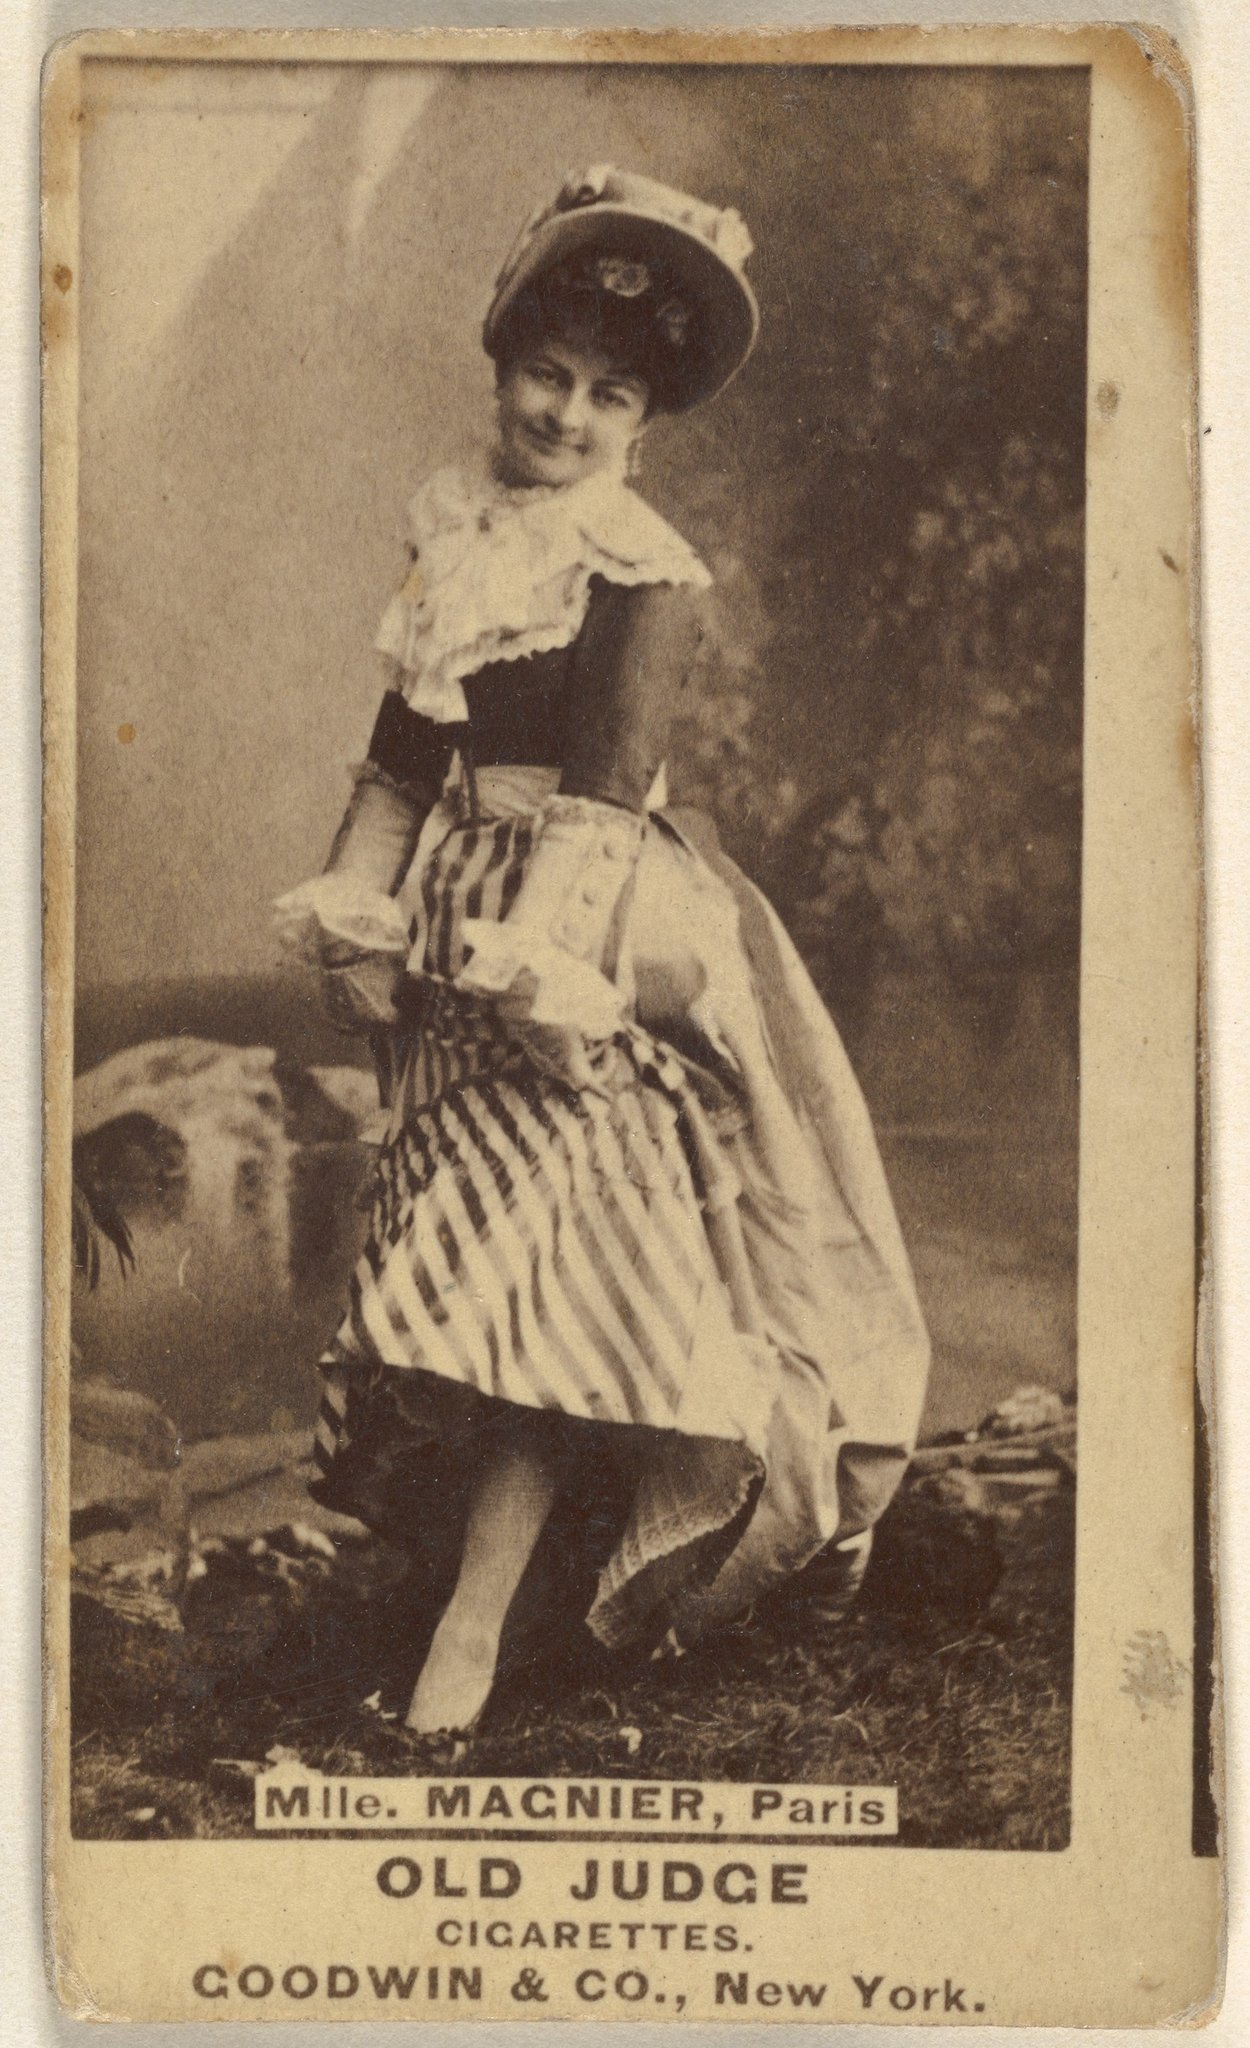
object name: photograph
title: Mlle. Magnier, Paris, from the Actors and Actresses series (N171) for Old Judge Cigarettes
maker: goodwin & company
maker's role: publisher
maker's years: 1850-1950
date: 1886-1890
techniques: albumen silver print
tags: portraits,women,actresses